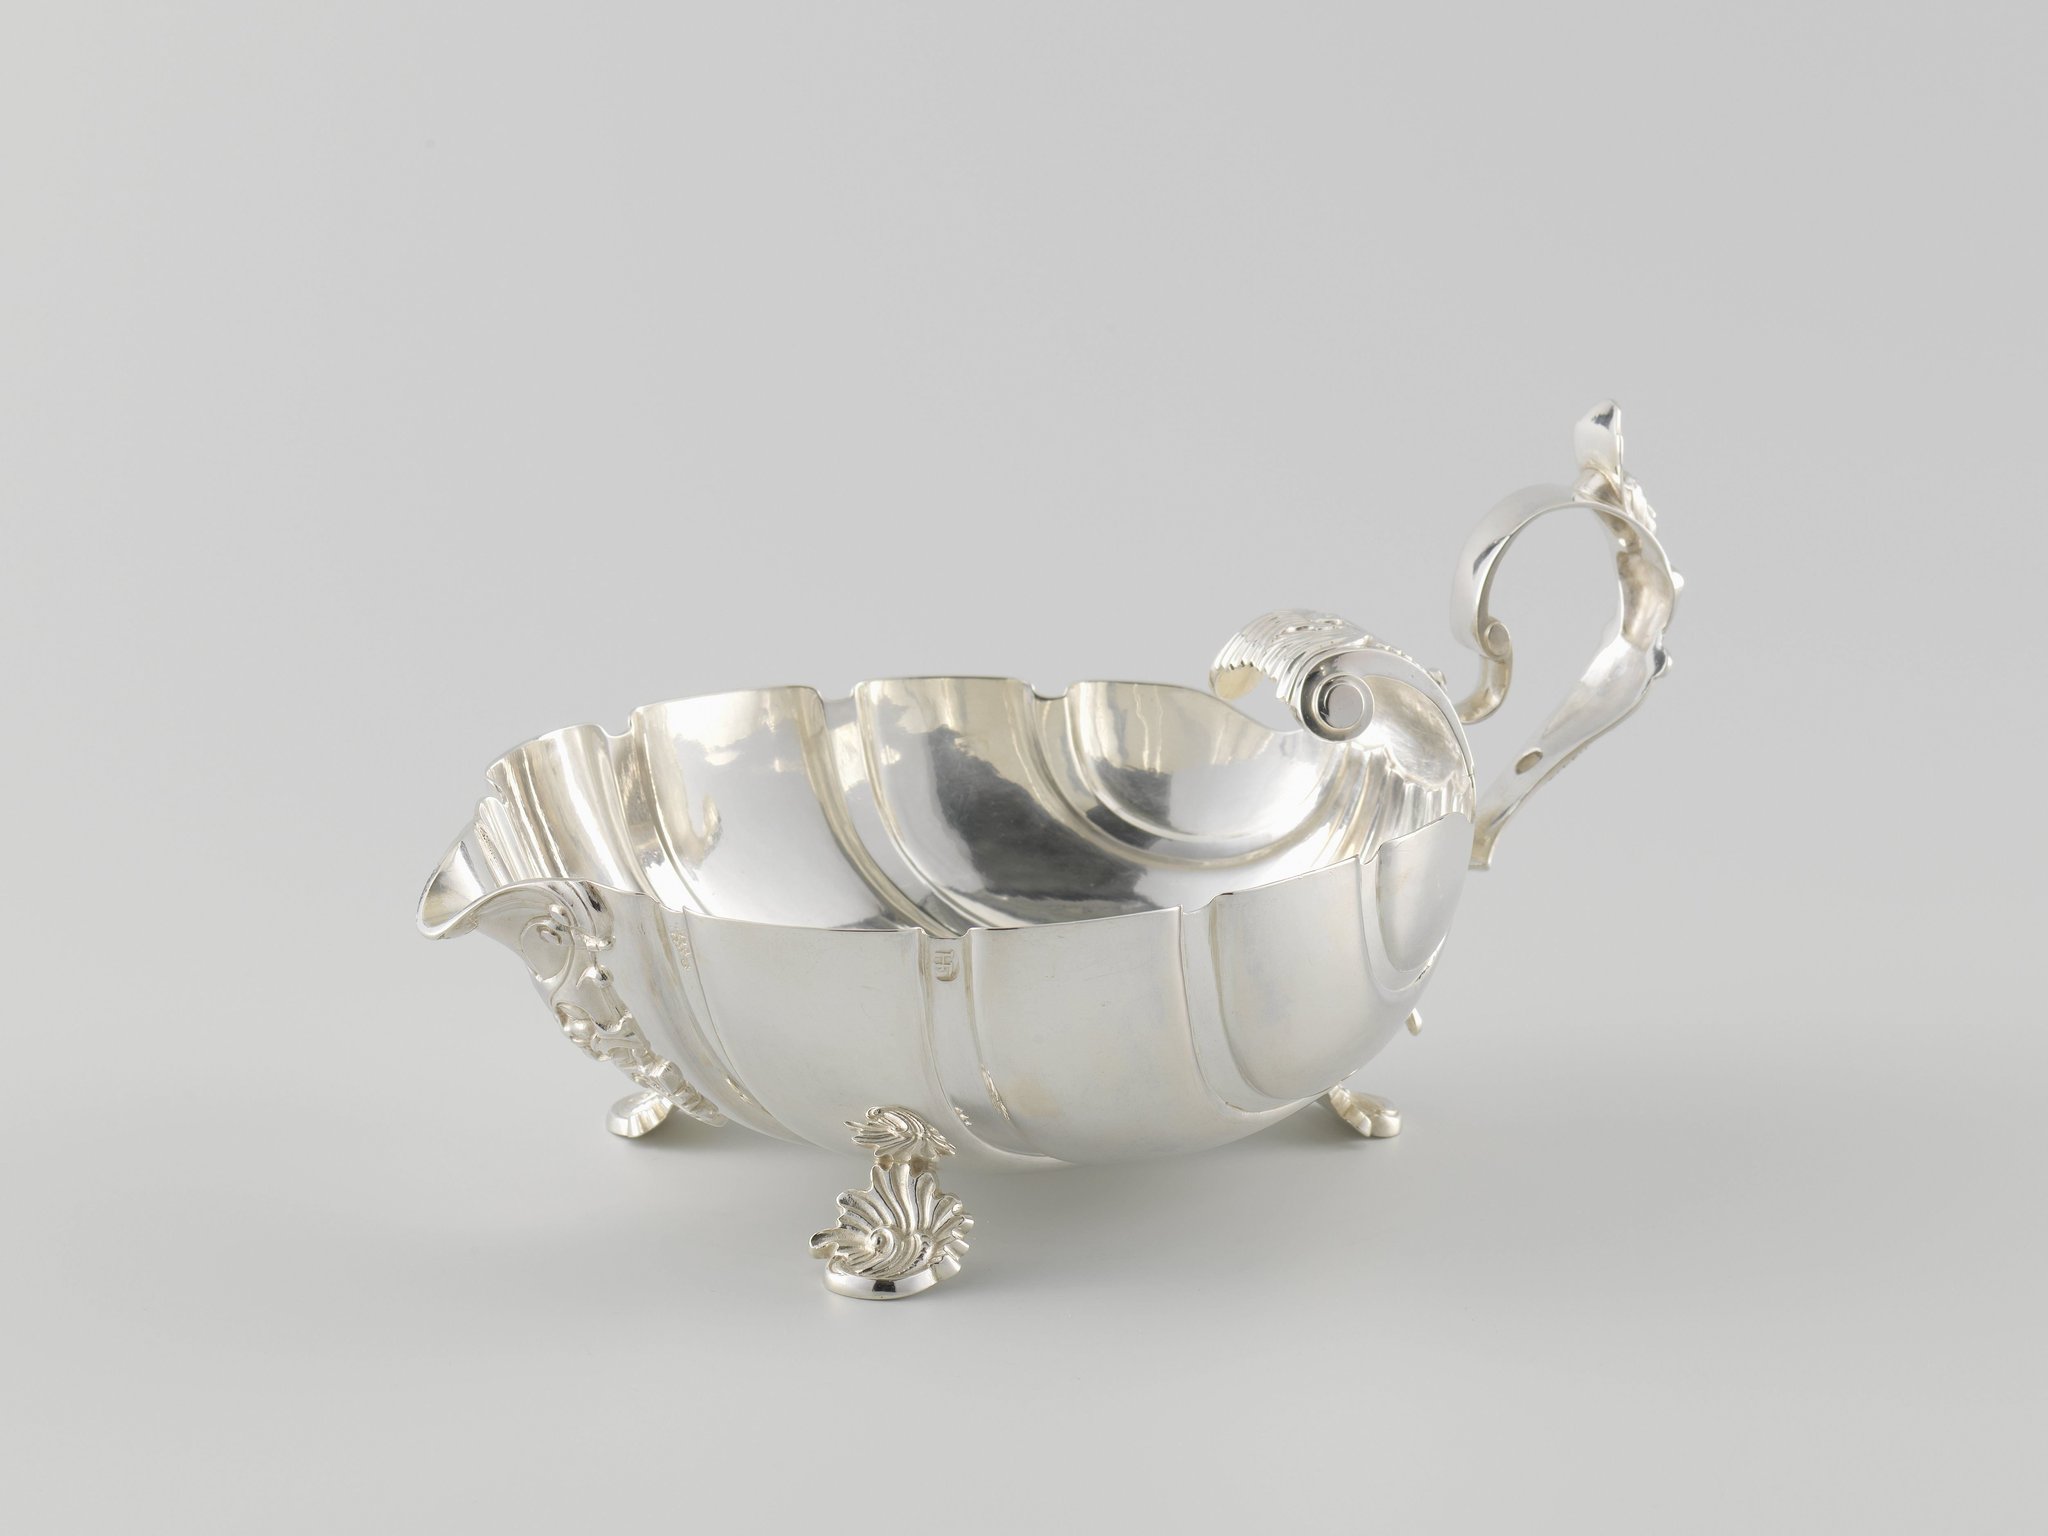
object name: sauceboat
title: Sauskom in schelpvorm met drie pootjes en oor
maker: hendrik fortman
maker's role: silversmith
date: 1767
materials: silver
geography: leiden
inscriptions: town mark: ‘Leiden’, maker's mark: ‘HF aaneen in ovaal schild’, date letter: ‘I (=1767)’, alloy mark: ‘Hollandse leeuw’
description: Sauskom van zilver. De ovale kom rust op drie pootjes in de vorm van kuifmotieven. In de lengterichting van het lichaam is een patroon gedreven van evenwijdig lopende gecurfde ribbels waarmee het uiterlijk van een schelp is gesuggereerd.De gegolfde bovenrand heeft aan de ene zijde een korte ingaande krul, versierd met een rocaille. Hieraan is een plat uit voluten opgebouwd oor, versierd met een gehelmde herm, bevestig. Aan de andere korte zijde van de bovenrand bevindt zich een ondiepe snebvormige monding, die aan de buitenzijde is versierd met gekrulde voluten boven een masker dat uitloopt in een kuifmotief.